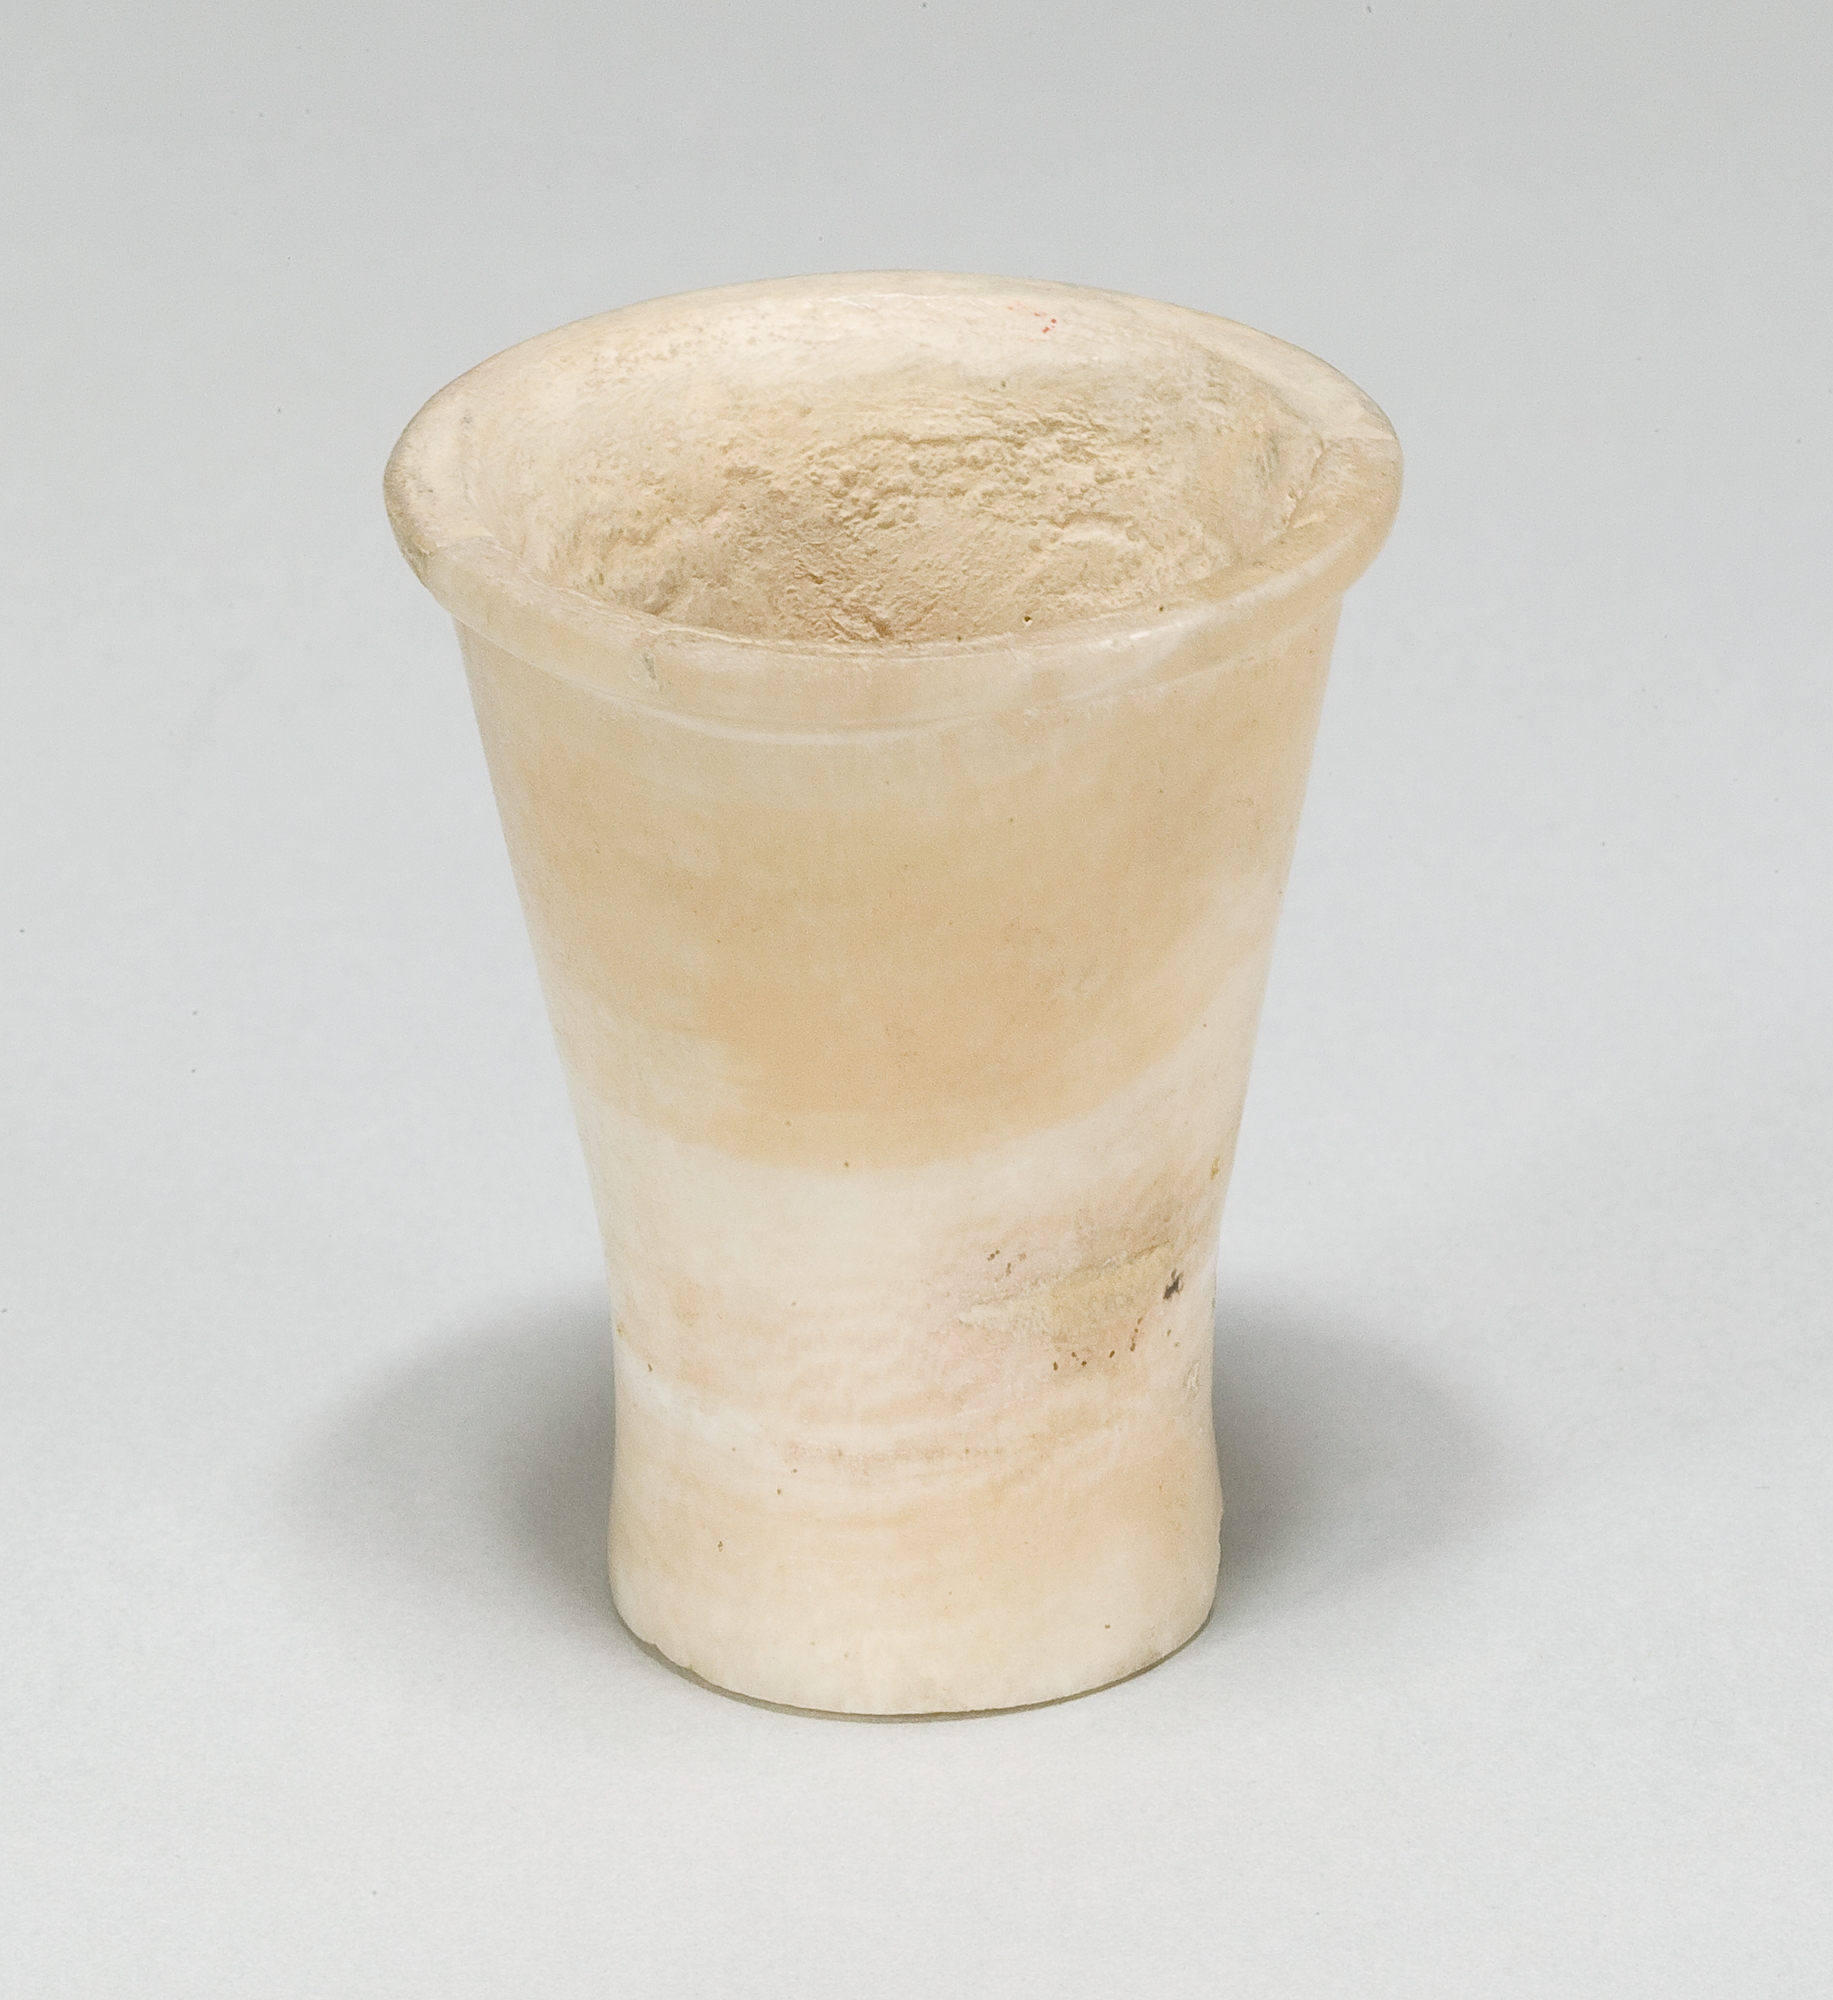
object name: miniature ointment jar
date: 1850-1775 BCE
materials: stone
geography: egypt